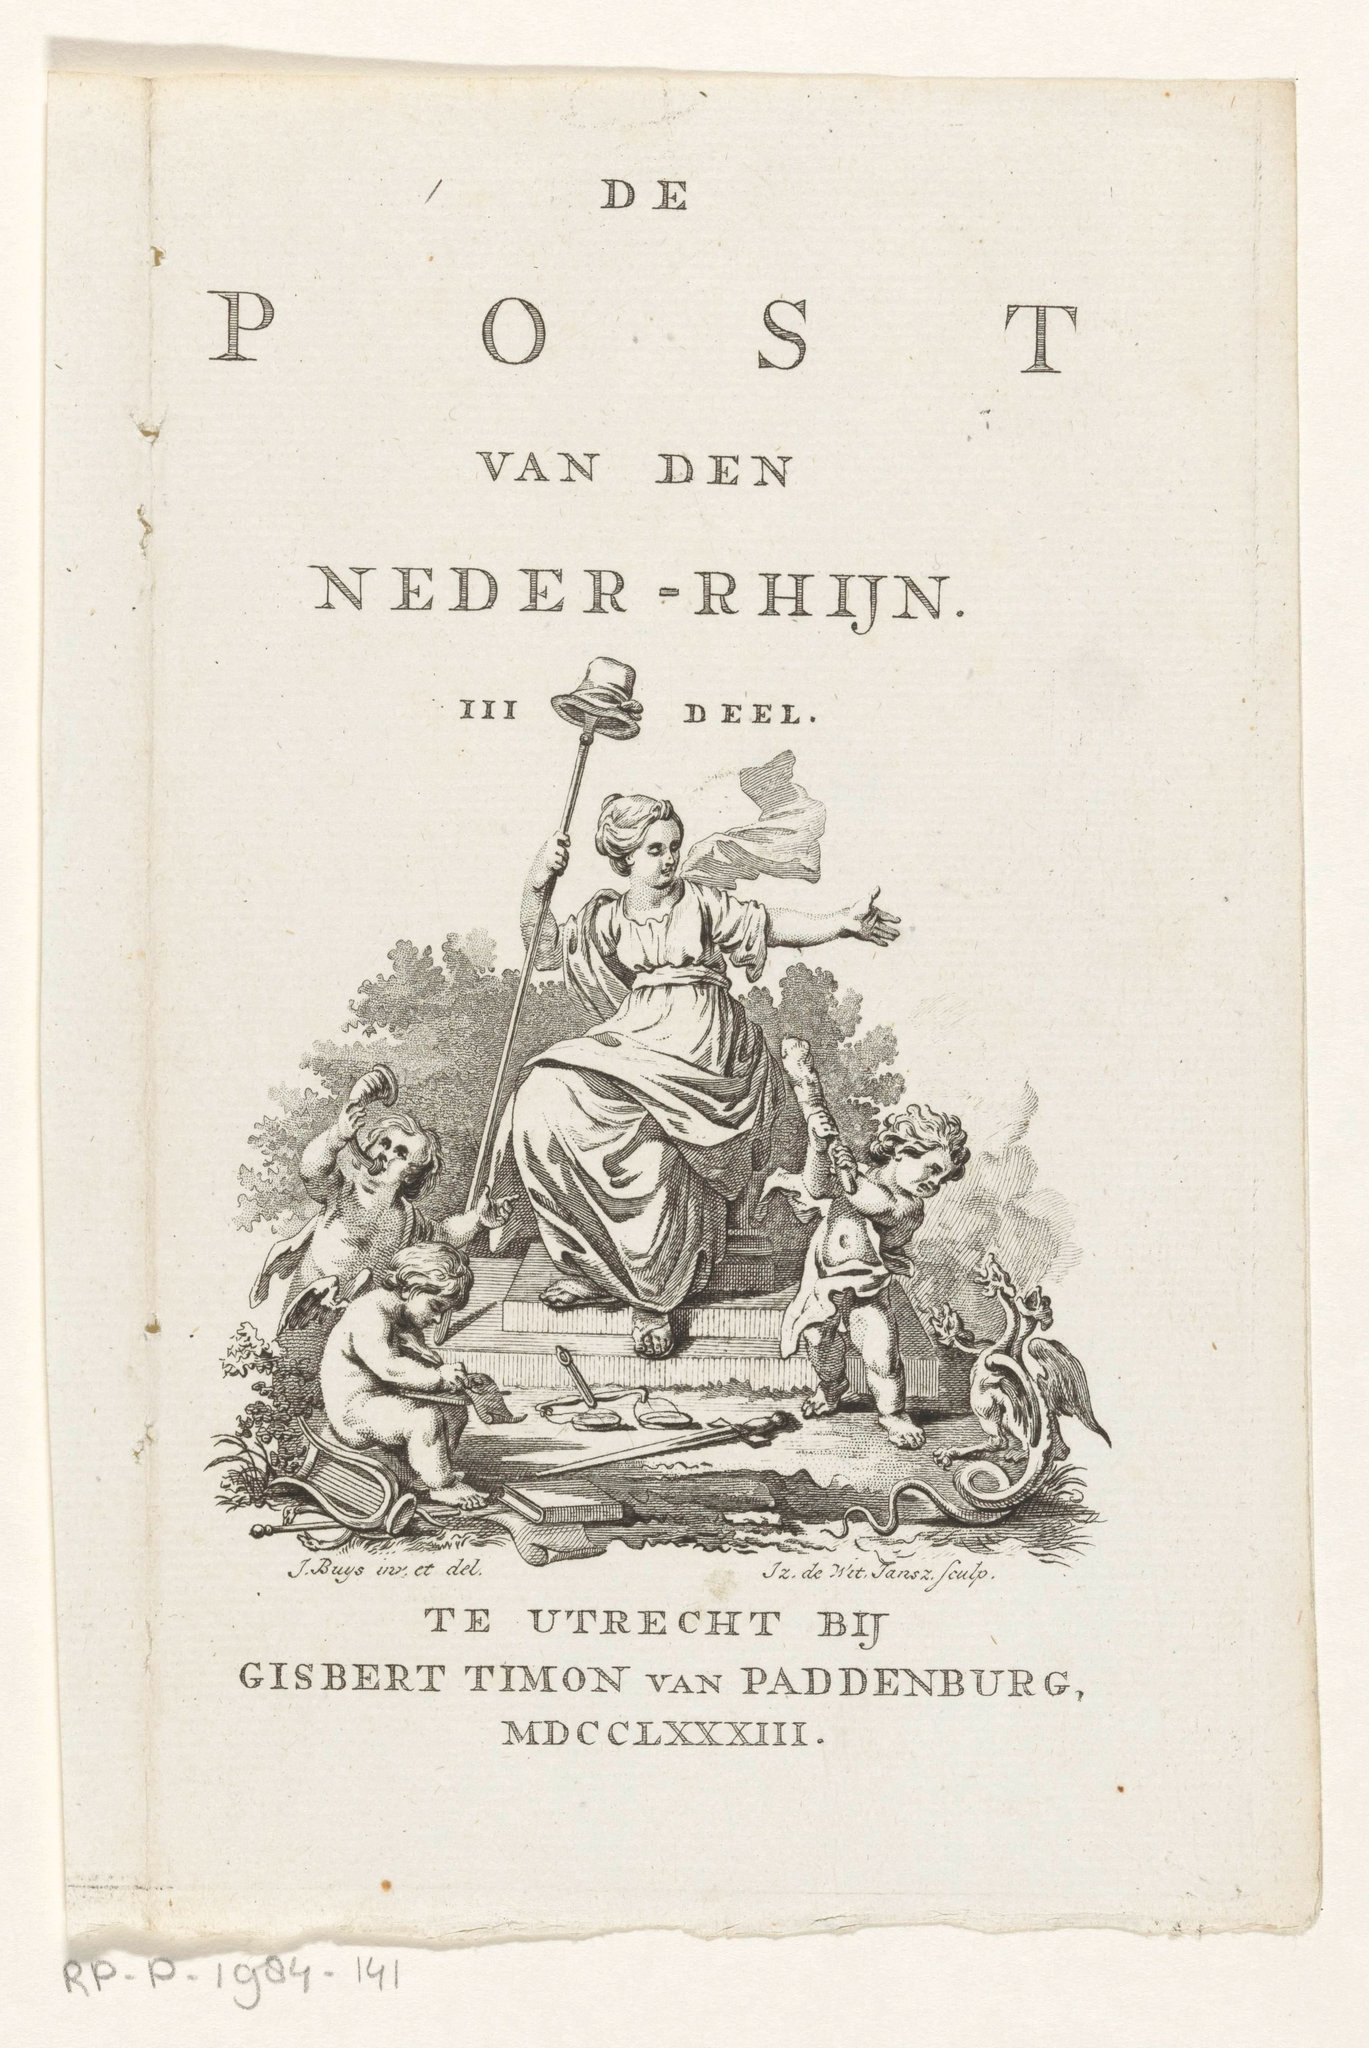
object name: print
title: Titelpagina voor: S.n., De Post van den Neder-Rhijn, 1783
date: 1783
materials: paper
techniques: engraving, etching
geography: utrecht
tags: monsters ~ snakes, freedom, liberty; 'libertà' (ripa) (+ abstract concept represented by female figure)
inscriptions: collector's mark: Lugt 2760, collector's mark: Lugt 2228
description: Vrijheid zit centraal op een verhoging. Links een putto met blazend op een bazuin en een schrijvende putto. Rechts verjaagt een putto een driekoppige slang.